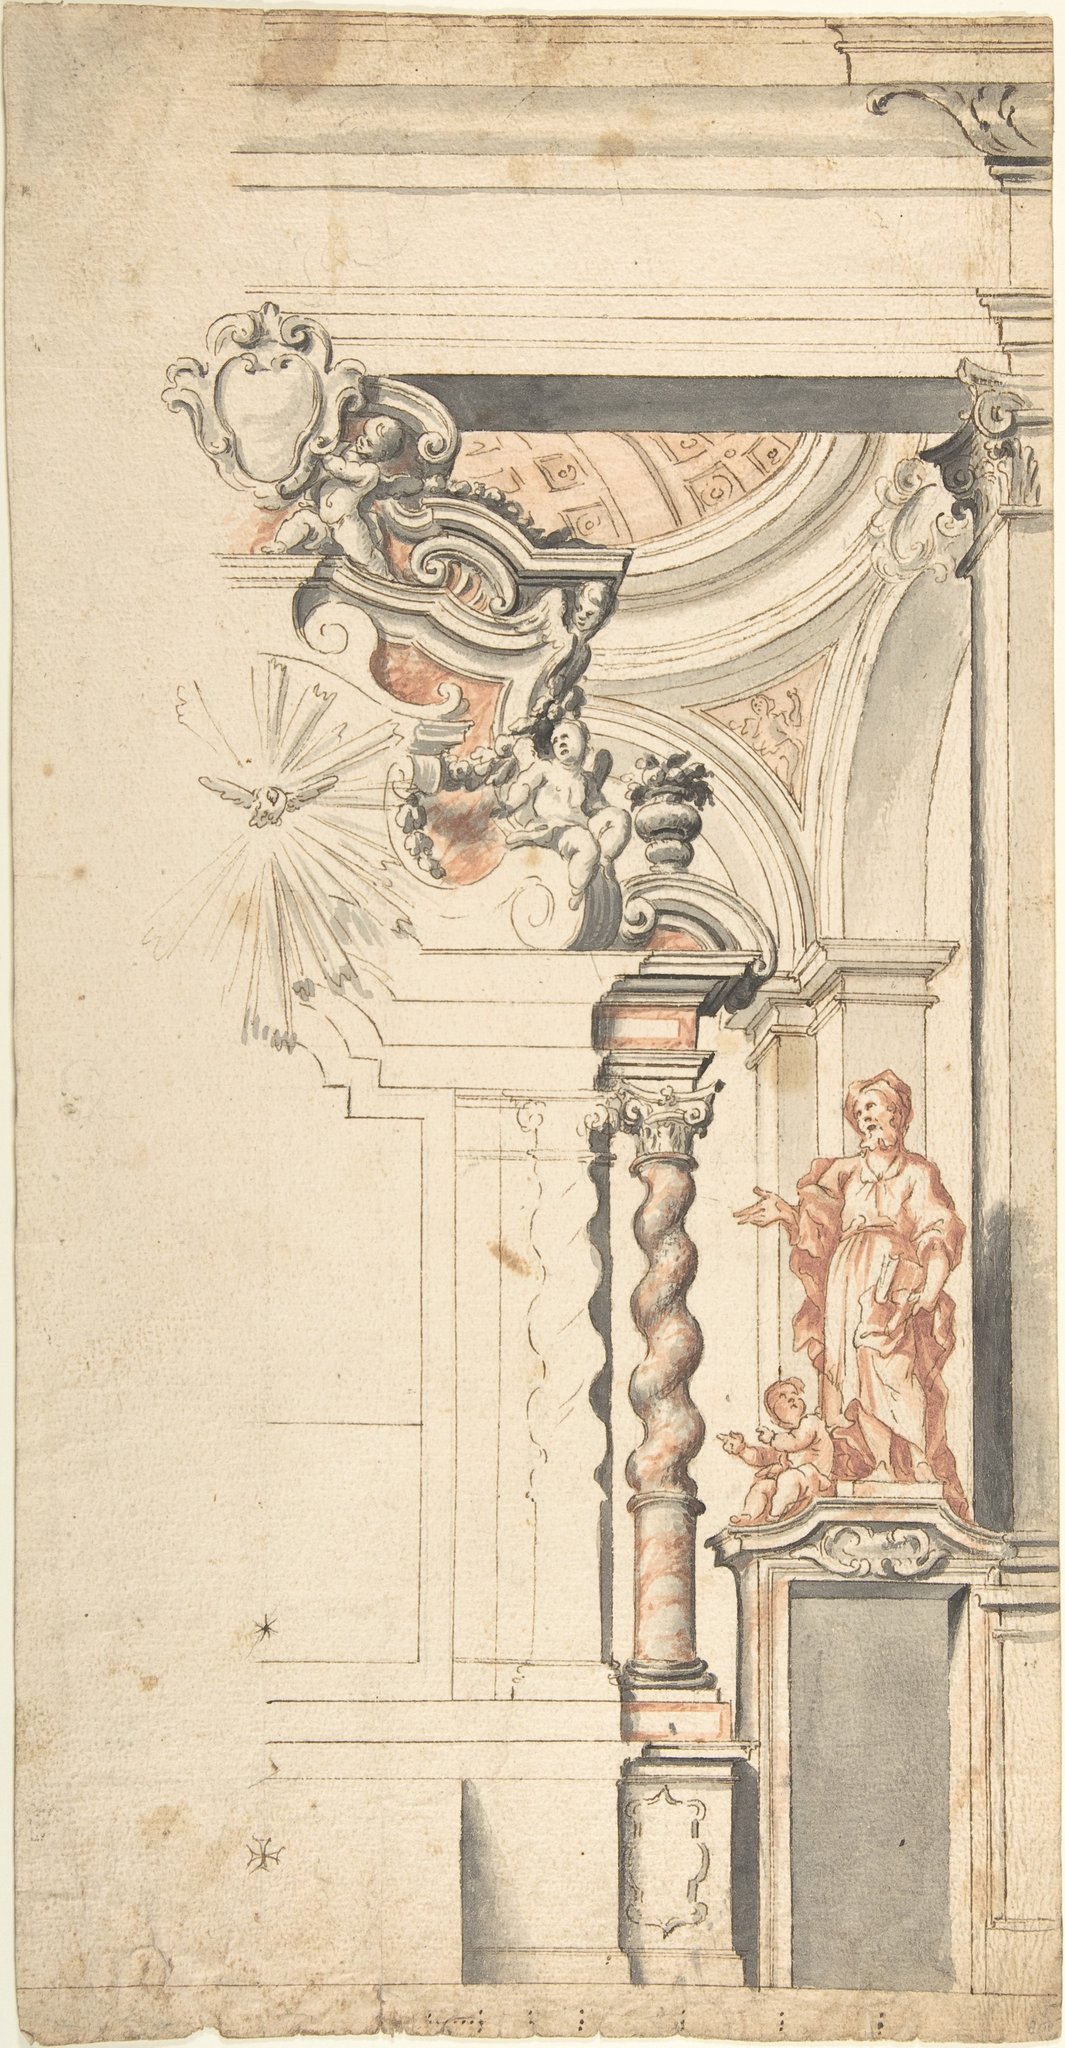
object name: drawing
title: Design for One Half a Chapel with the Dove of the Holy Ghost above the Main Altar, and a Statue of an Evangelist at right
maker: anonymous, italian, piedmontese, 18th century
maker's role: artist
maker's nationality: italian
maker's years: 1700-1800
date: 1700-1780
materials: chalk, ink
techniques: brush, pen, wash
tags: birds,cupid,saint john the evangelist